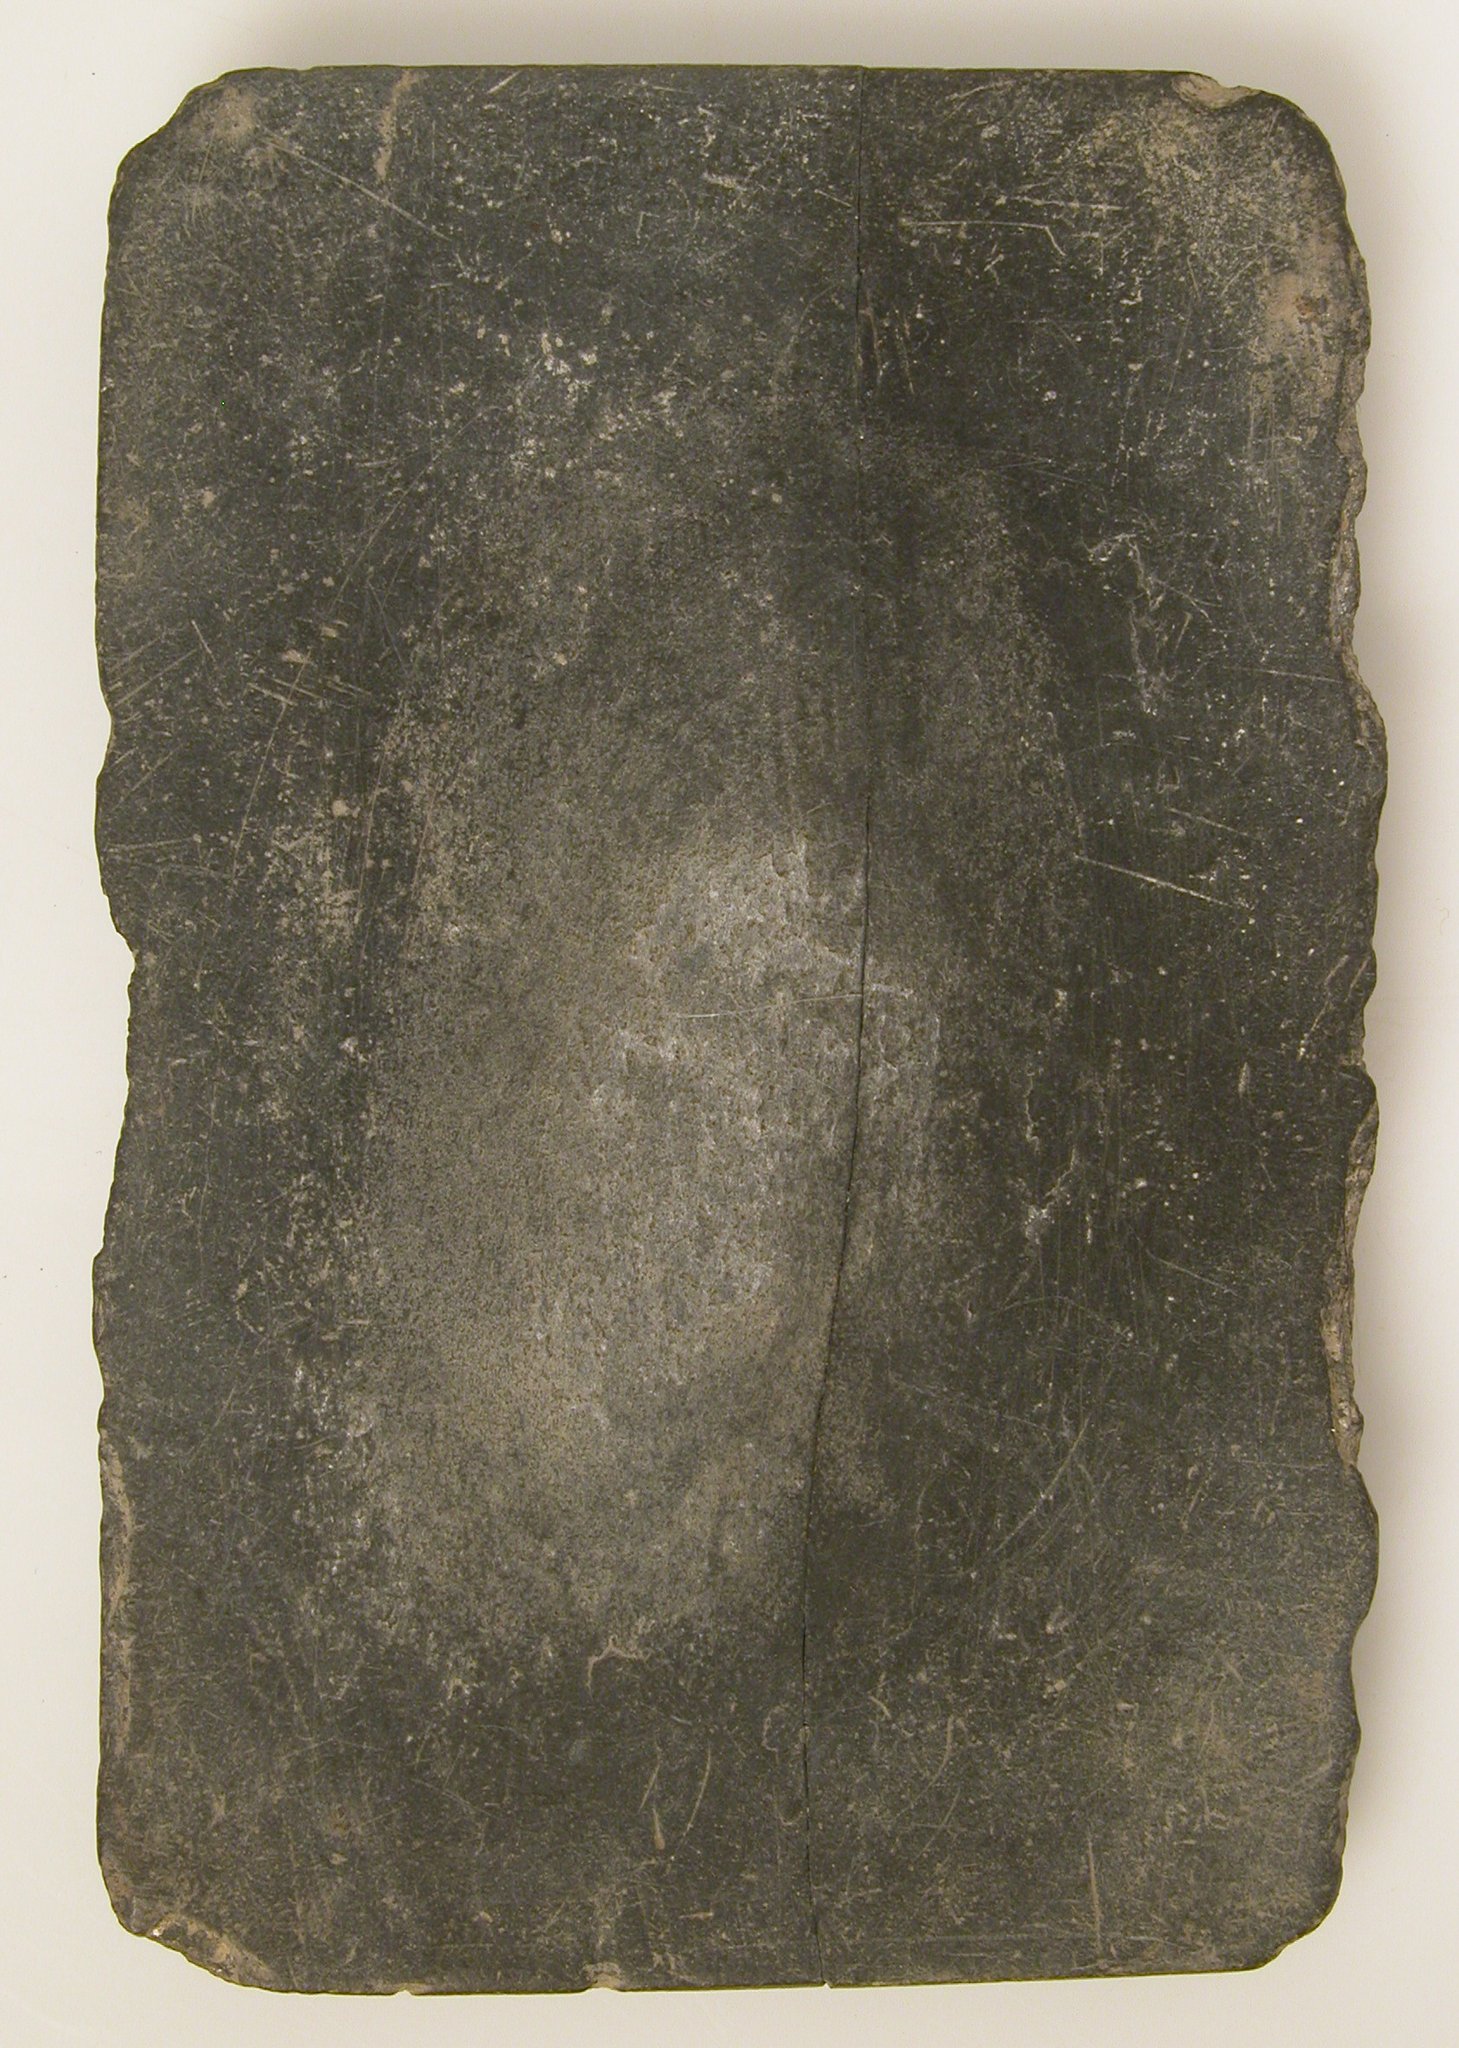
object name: palette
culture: coptic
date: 301-700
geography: egypt